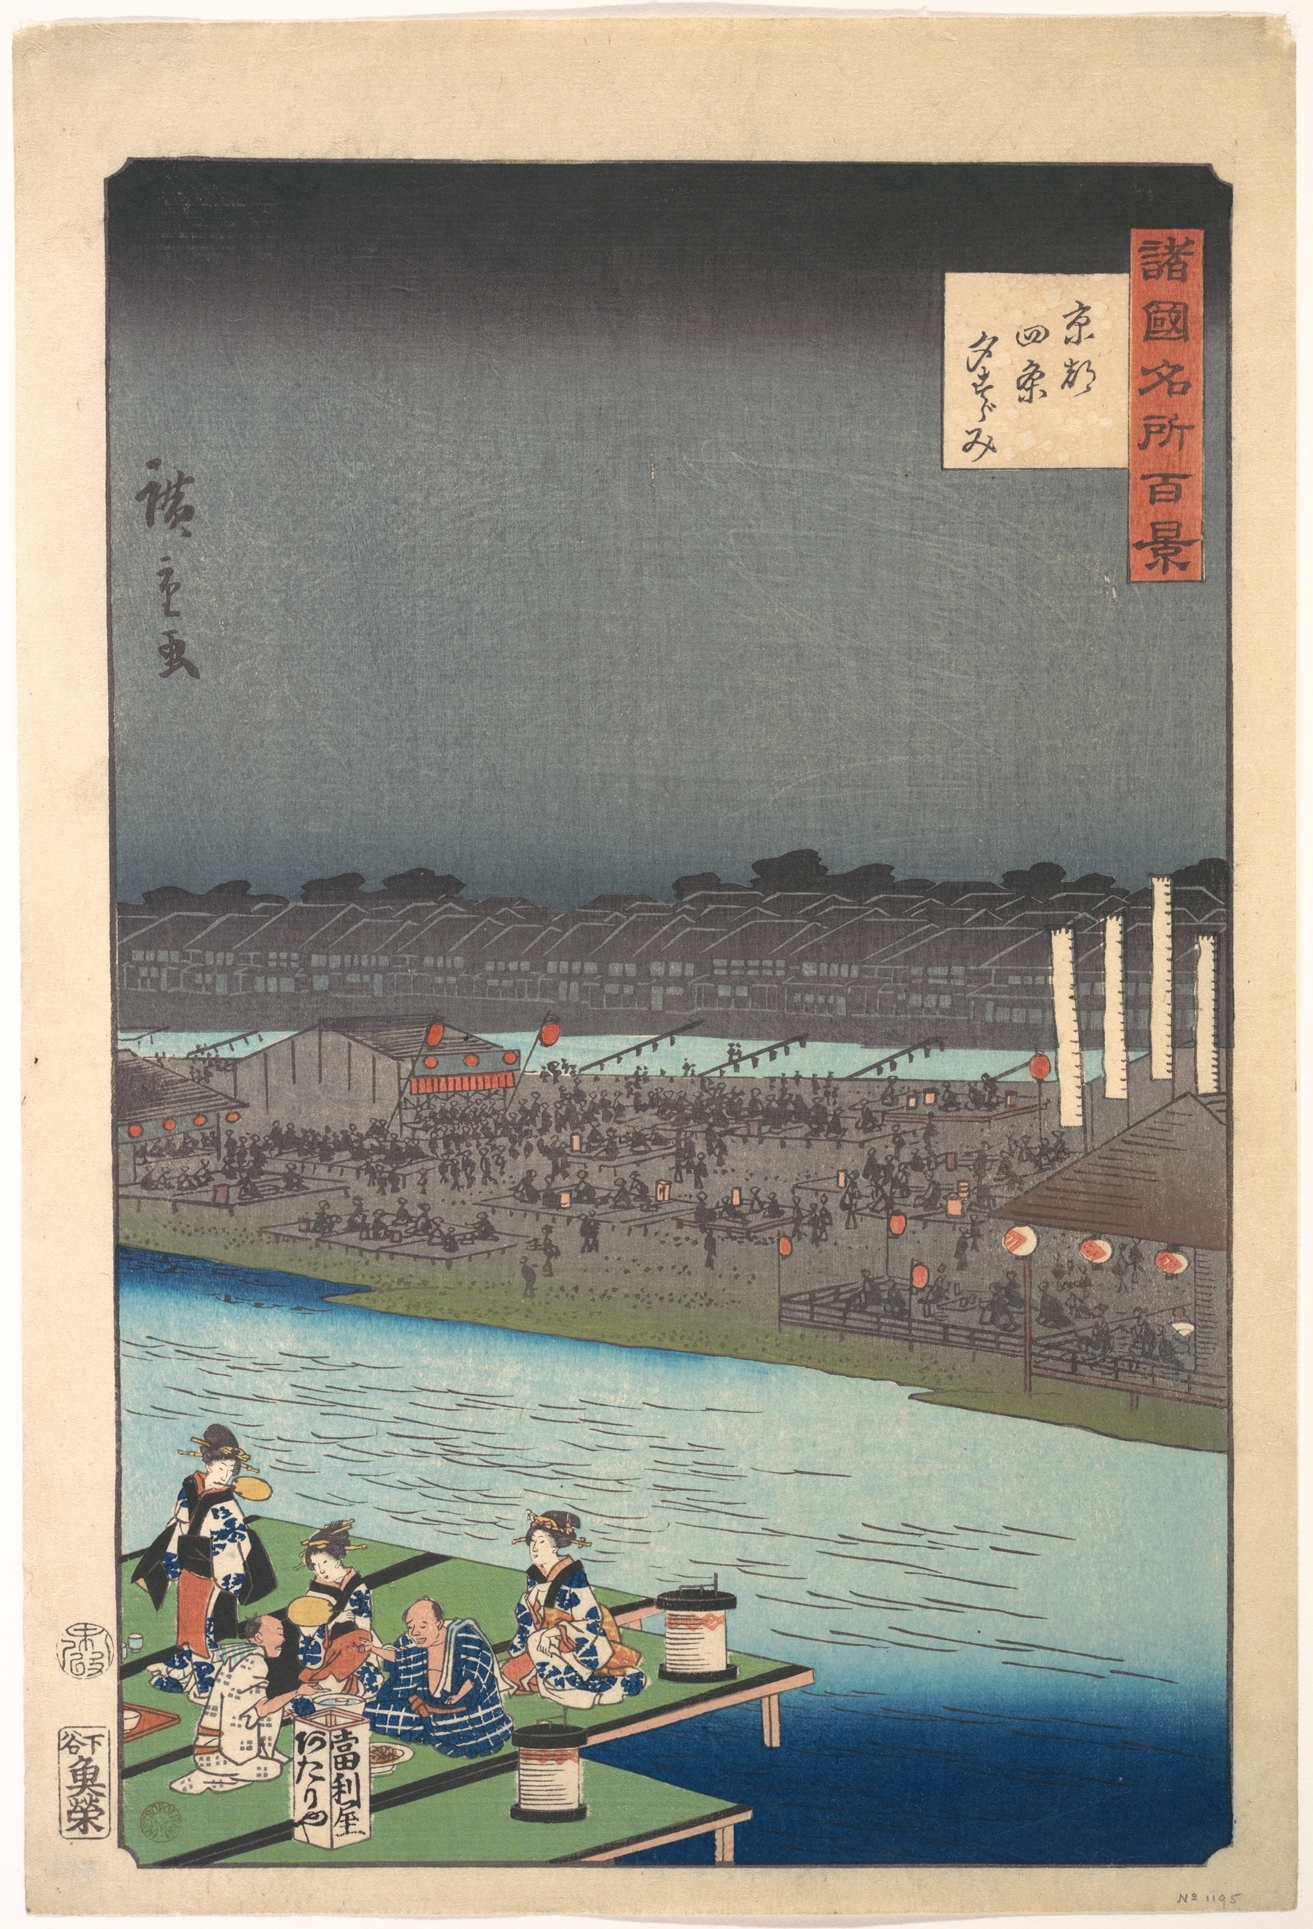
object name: print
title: Enjoying the Evening Cool at Shijō in Kyoto, from the series One Hundred Famous Views in the Various Provinces (Shokoku meisho hyakkei)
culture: japanese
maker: utagawa hiroshige ii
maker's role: artist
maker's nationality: japanese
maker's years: 1826-1869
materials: ink, paper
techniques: woodblock print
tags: men,women,streams